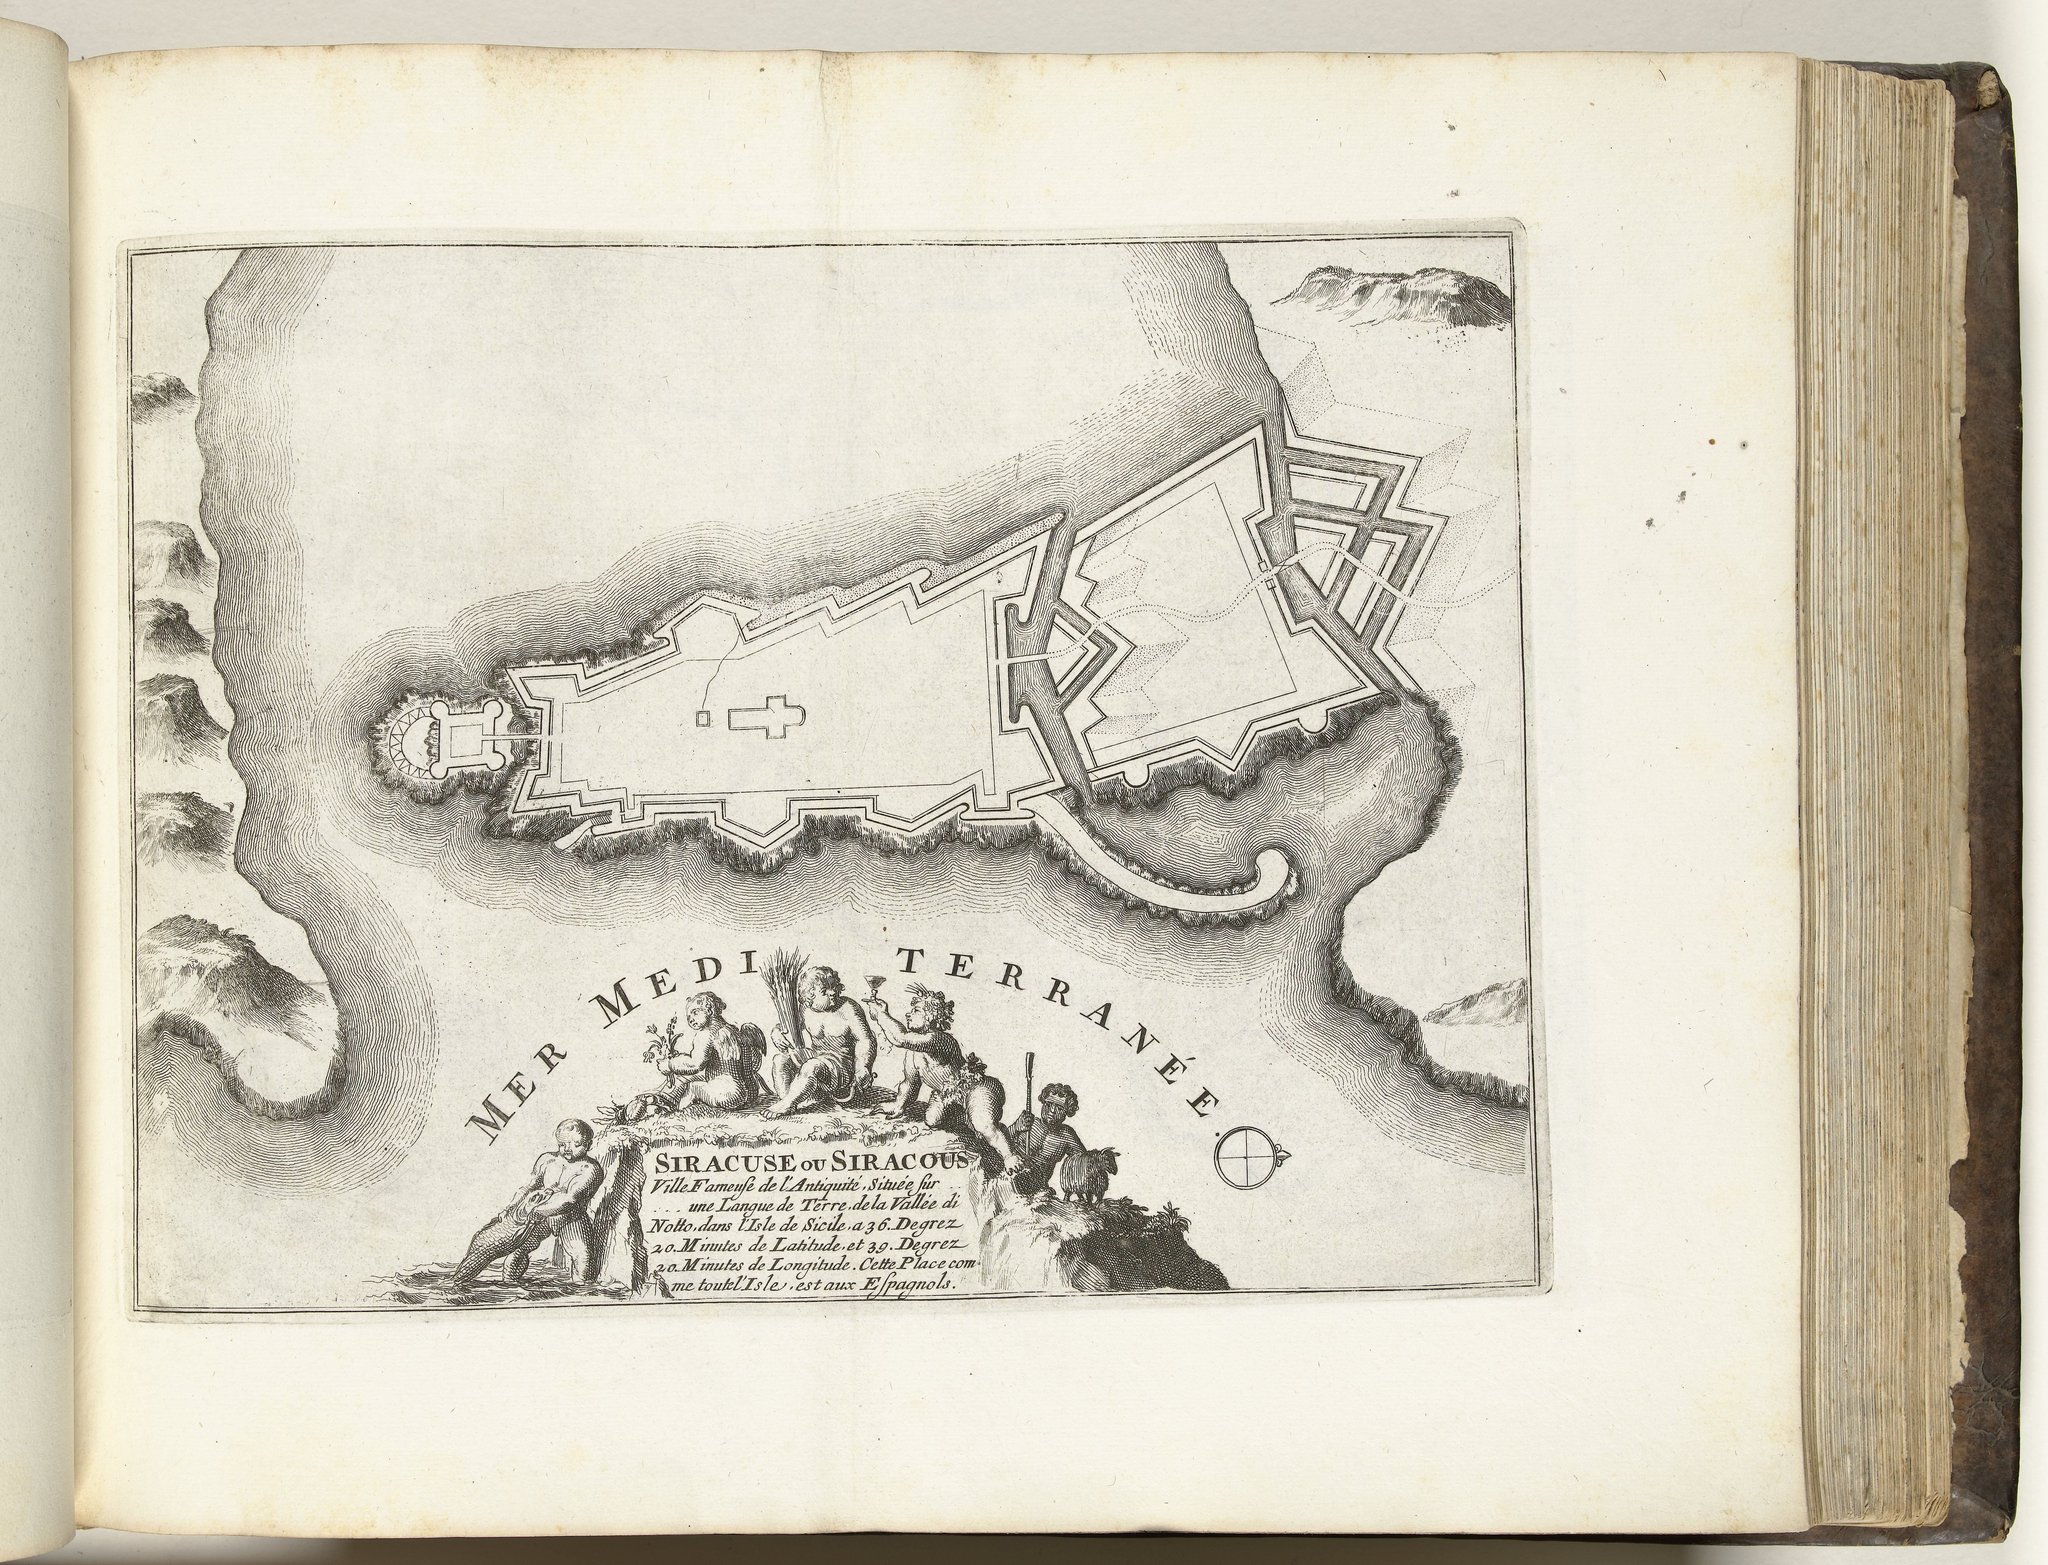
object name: print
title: Plattegrond van Siracusa, ca. 1695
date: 1695-1697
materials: paper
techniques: etching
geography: paris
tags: fortress, maps of cities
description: Plattegrond van de versterkingen om de Siciliaanse stad Siracusa. Onderdeel van het vierde deel (1697) van het prentwerk waarin gebundeld zijn de acht delen van Les forces de l'Europe uitgegeven tussen 1693-1697. Het prentwerk bestaat uit 175 platen met plannen (afkomstig van Sébastien Le Prestre, Seigneur de Vauban) van vermaarde sterke steden en vestingen in de Negenjarige Oorlog. Titel en opschriften in het Frans.